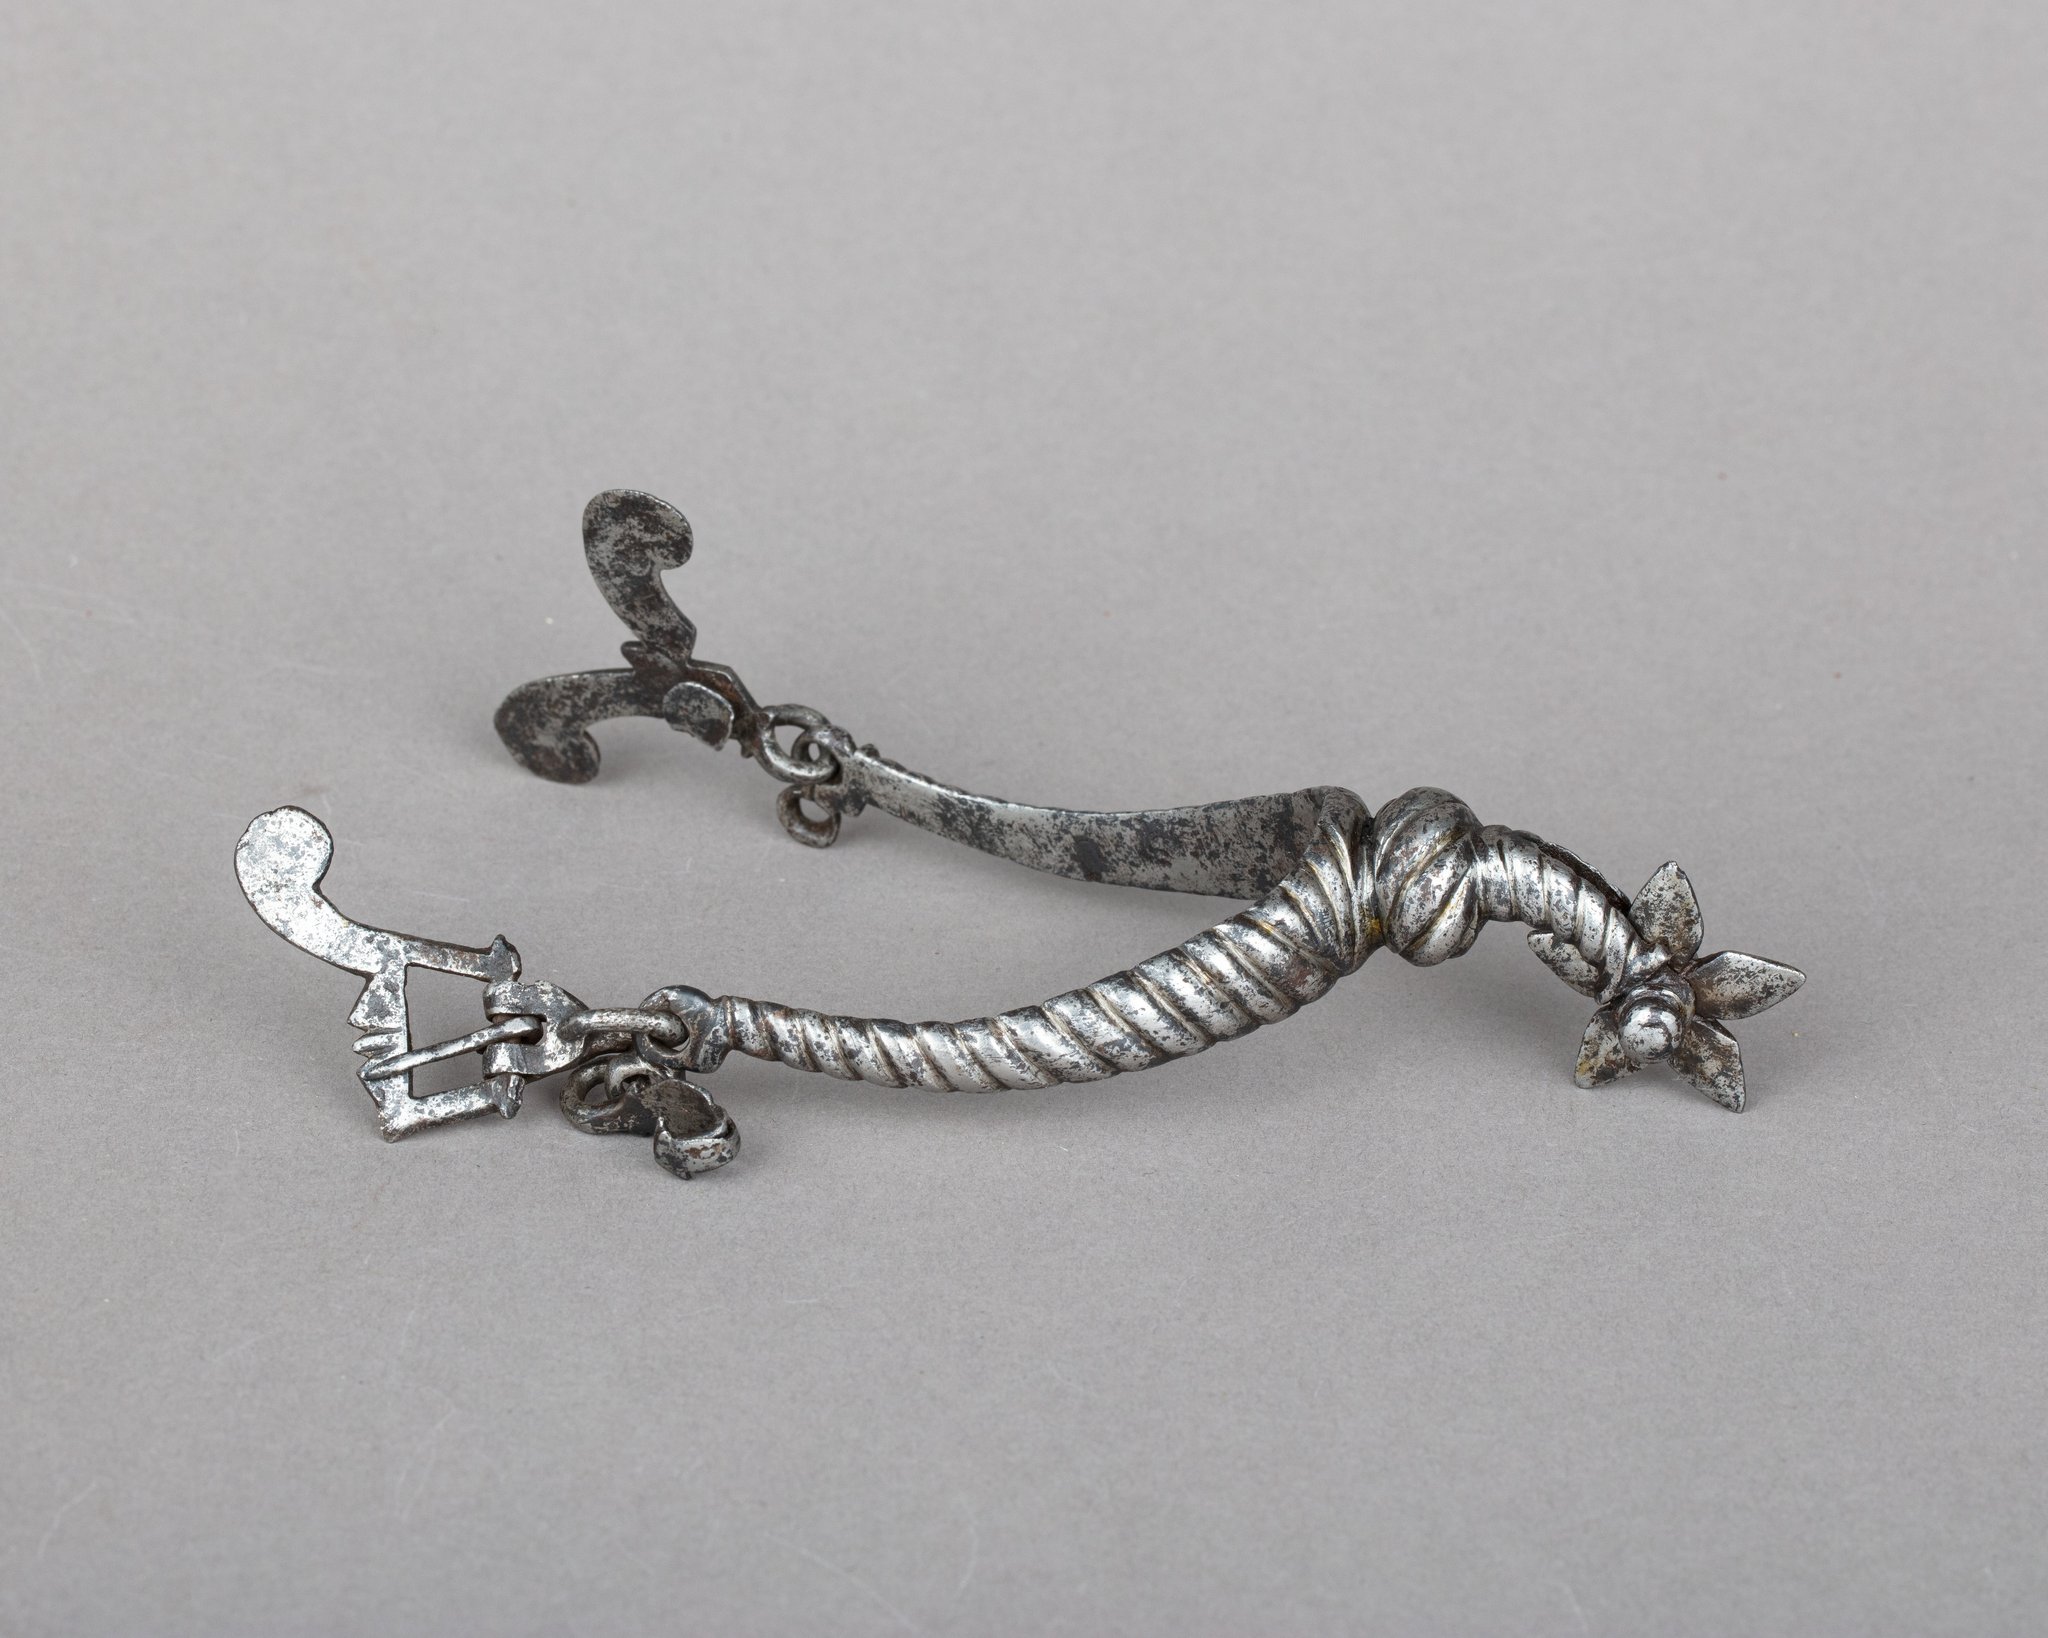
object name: spur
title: Rowel Spur (Left)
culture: german or spanish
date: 1601-1700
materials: metal alloy, tin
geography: spain